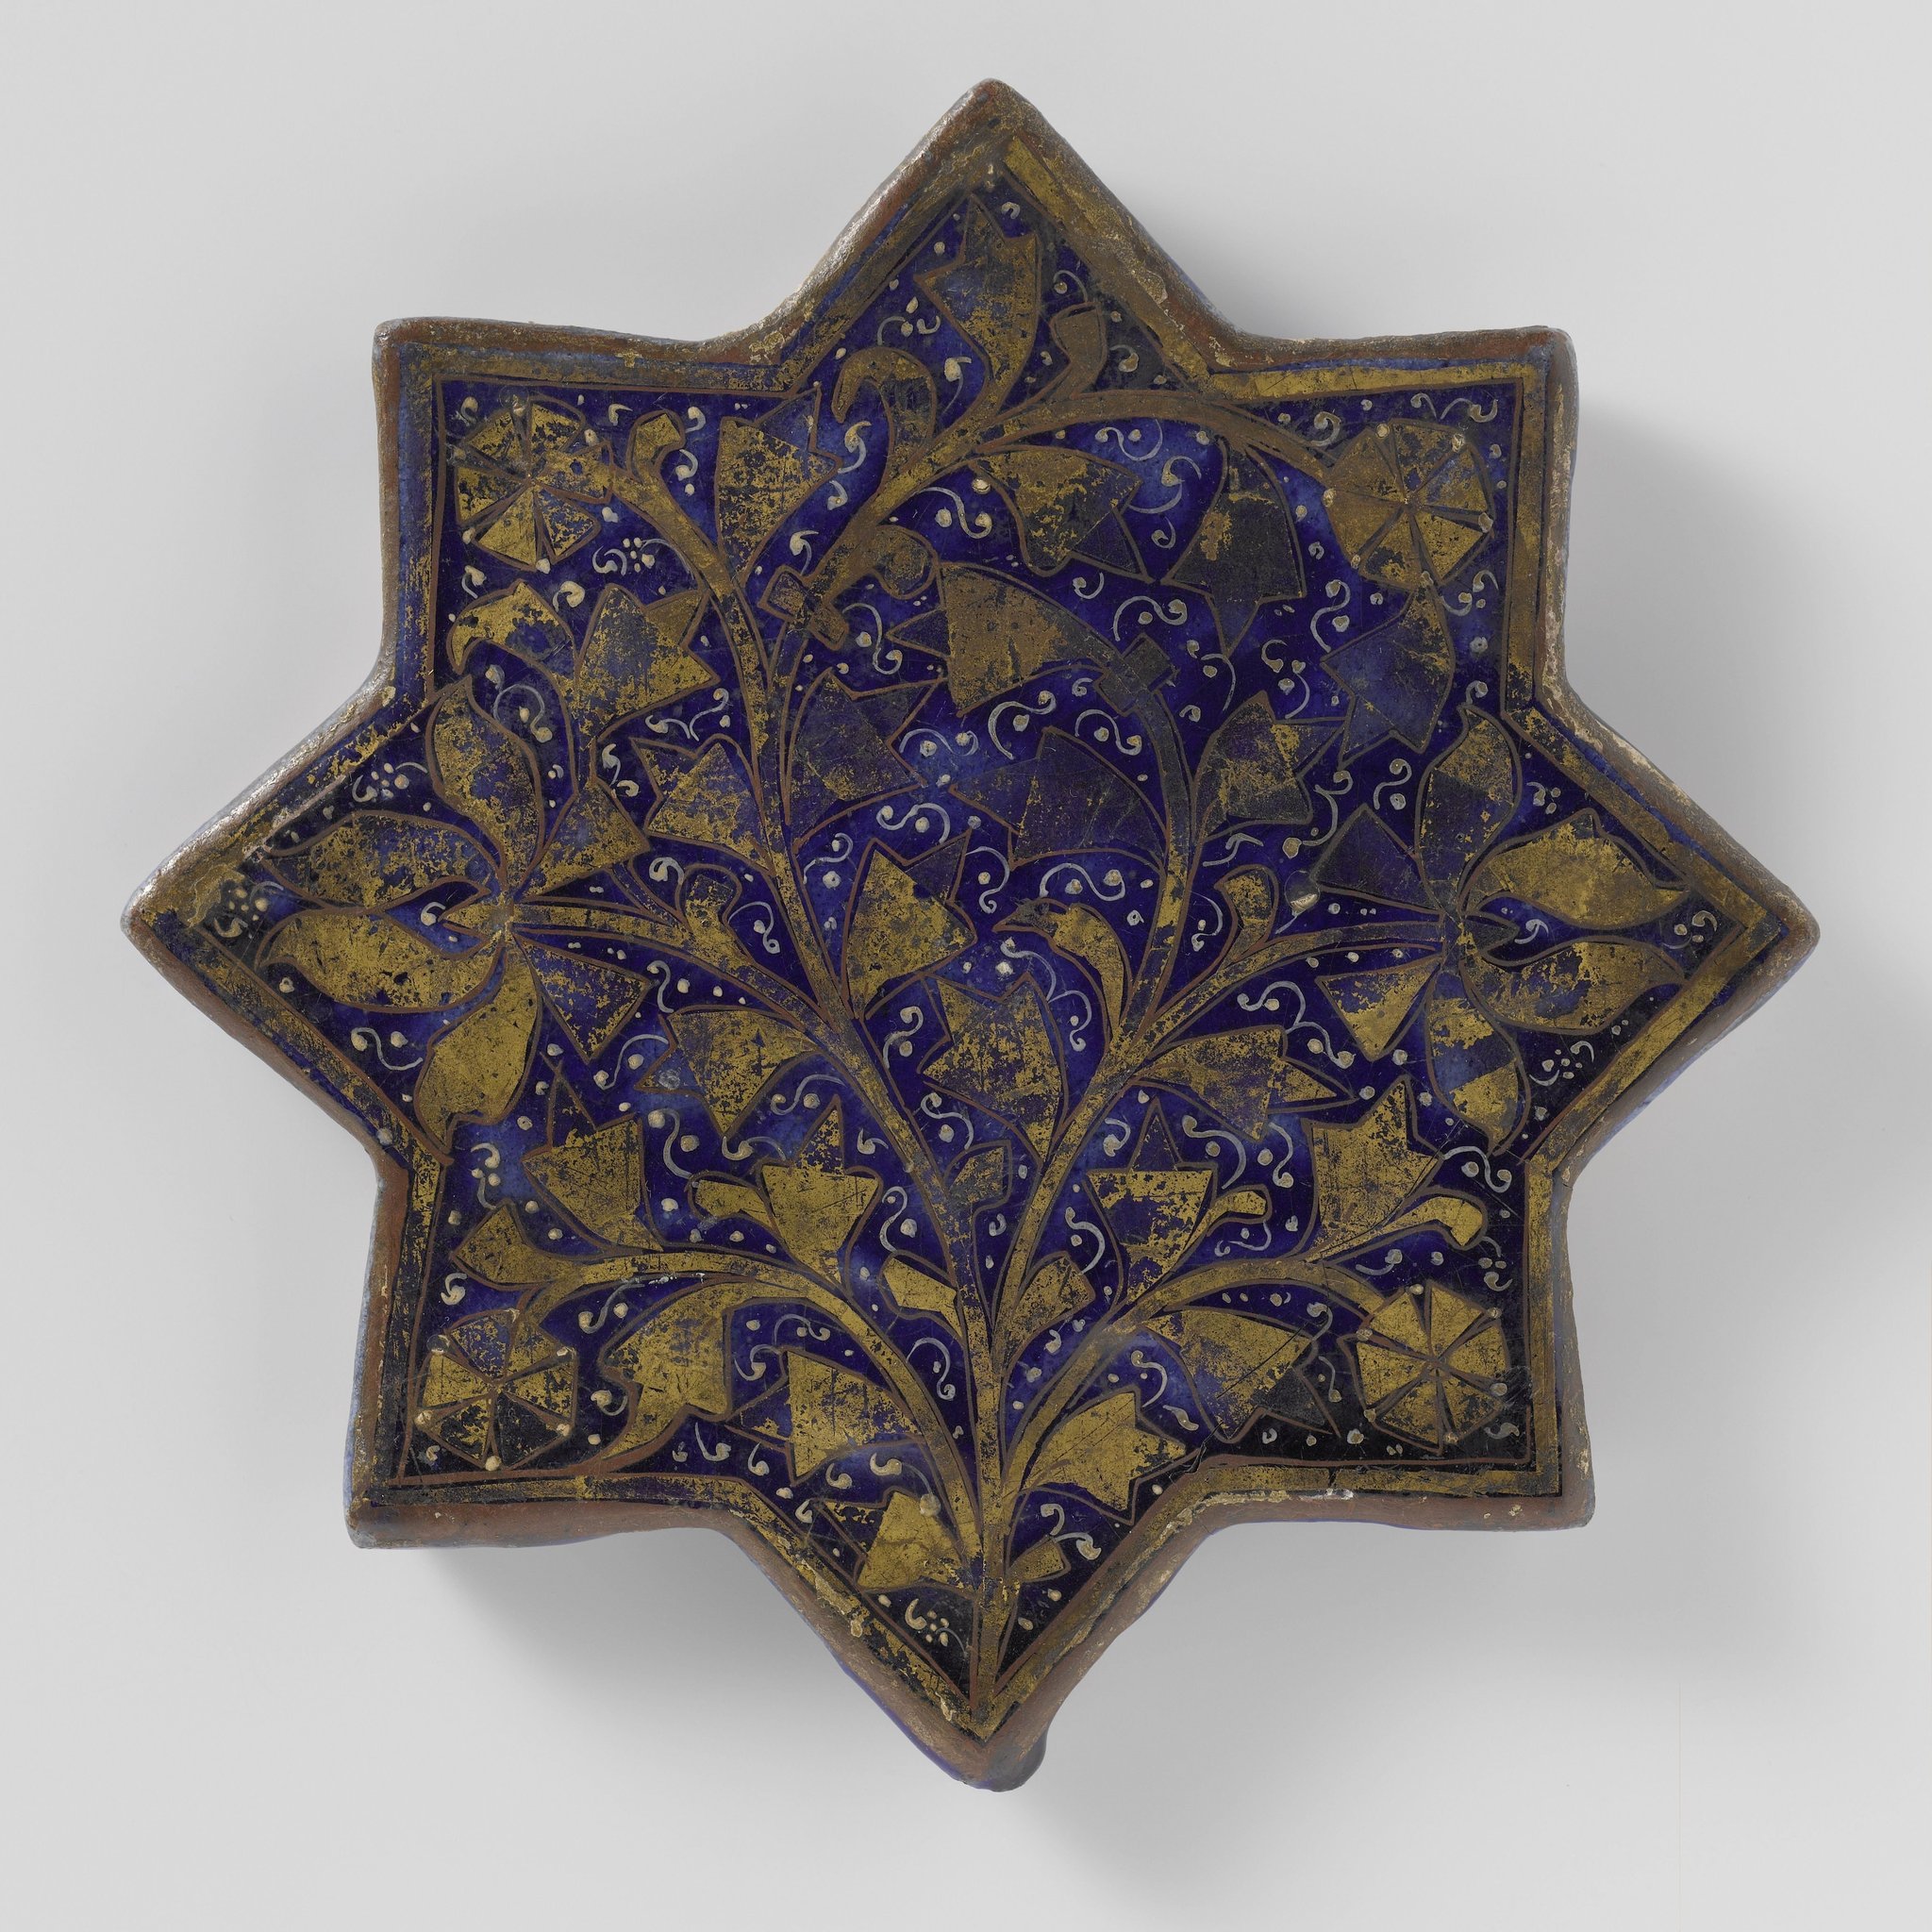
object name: tile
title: Star-shaped tile with a stylized flowering plant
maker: Anonymous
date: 1250-1299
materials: cobalt, earthenware, glaze, gold, paint, quartz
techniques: firing, forming, vitrification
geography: iran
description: Stervormige tegel met een gestileerde bloeiende plant (lotus) en florale motieven in goud op een kobalt blauwe ondergrond. Ladjvardina.